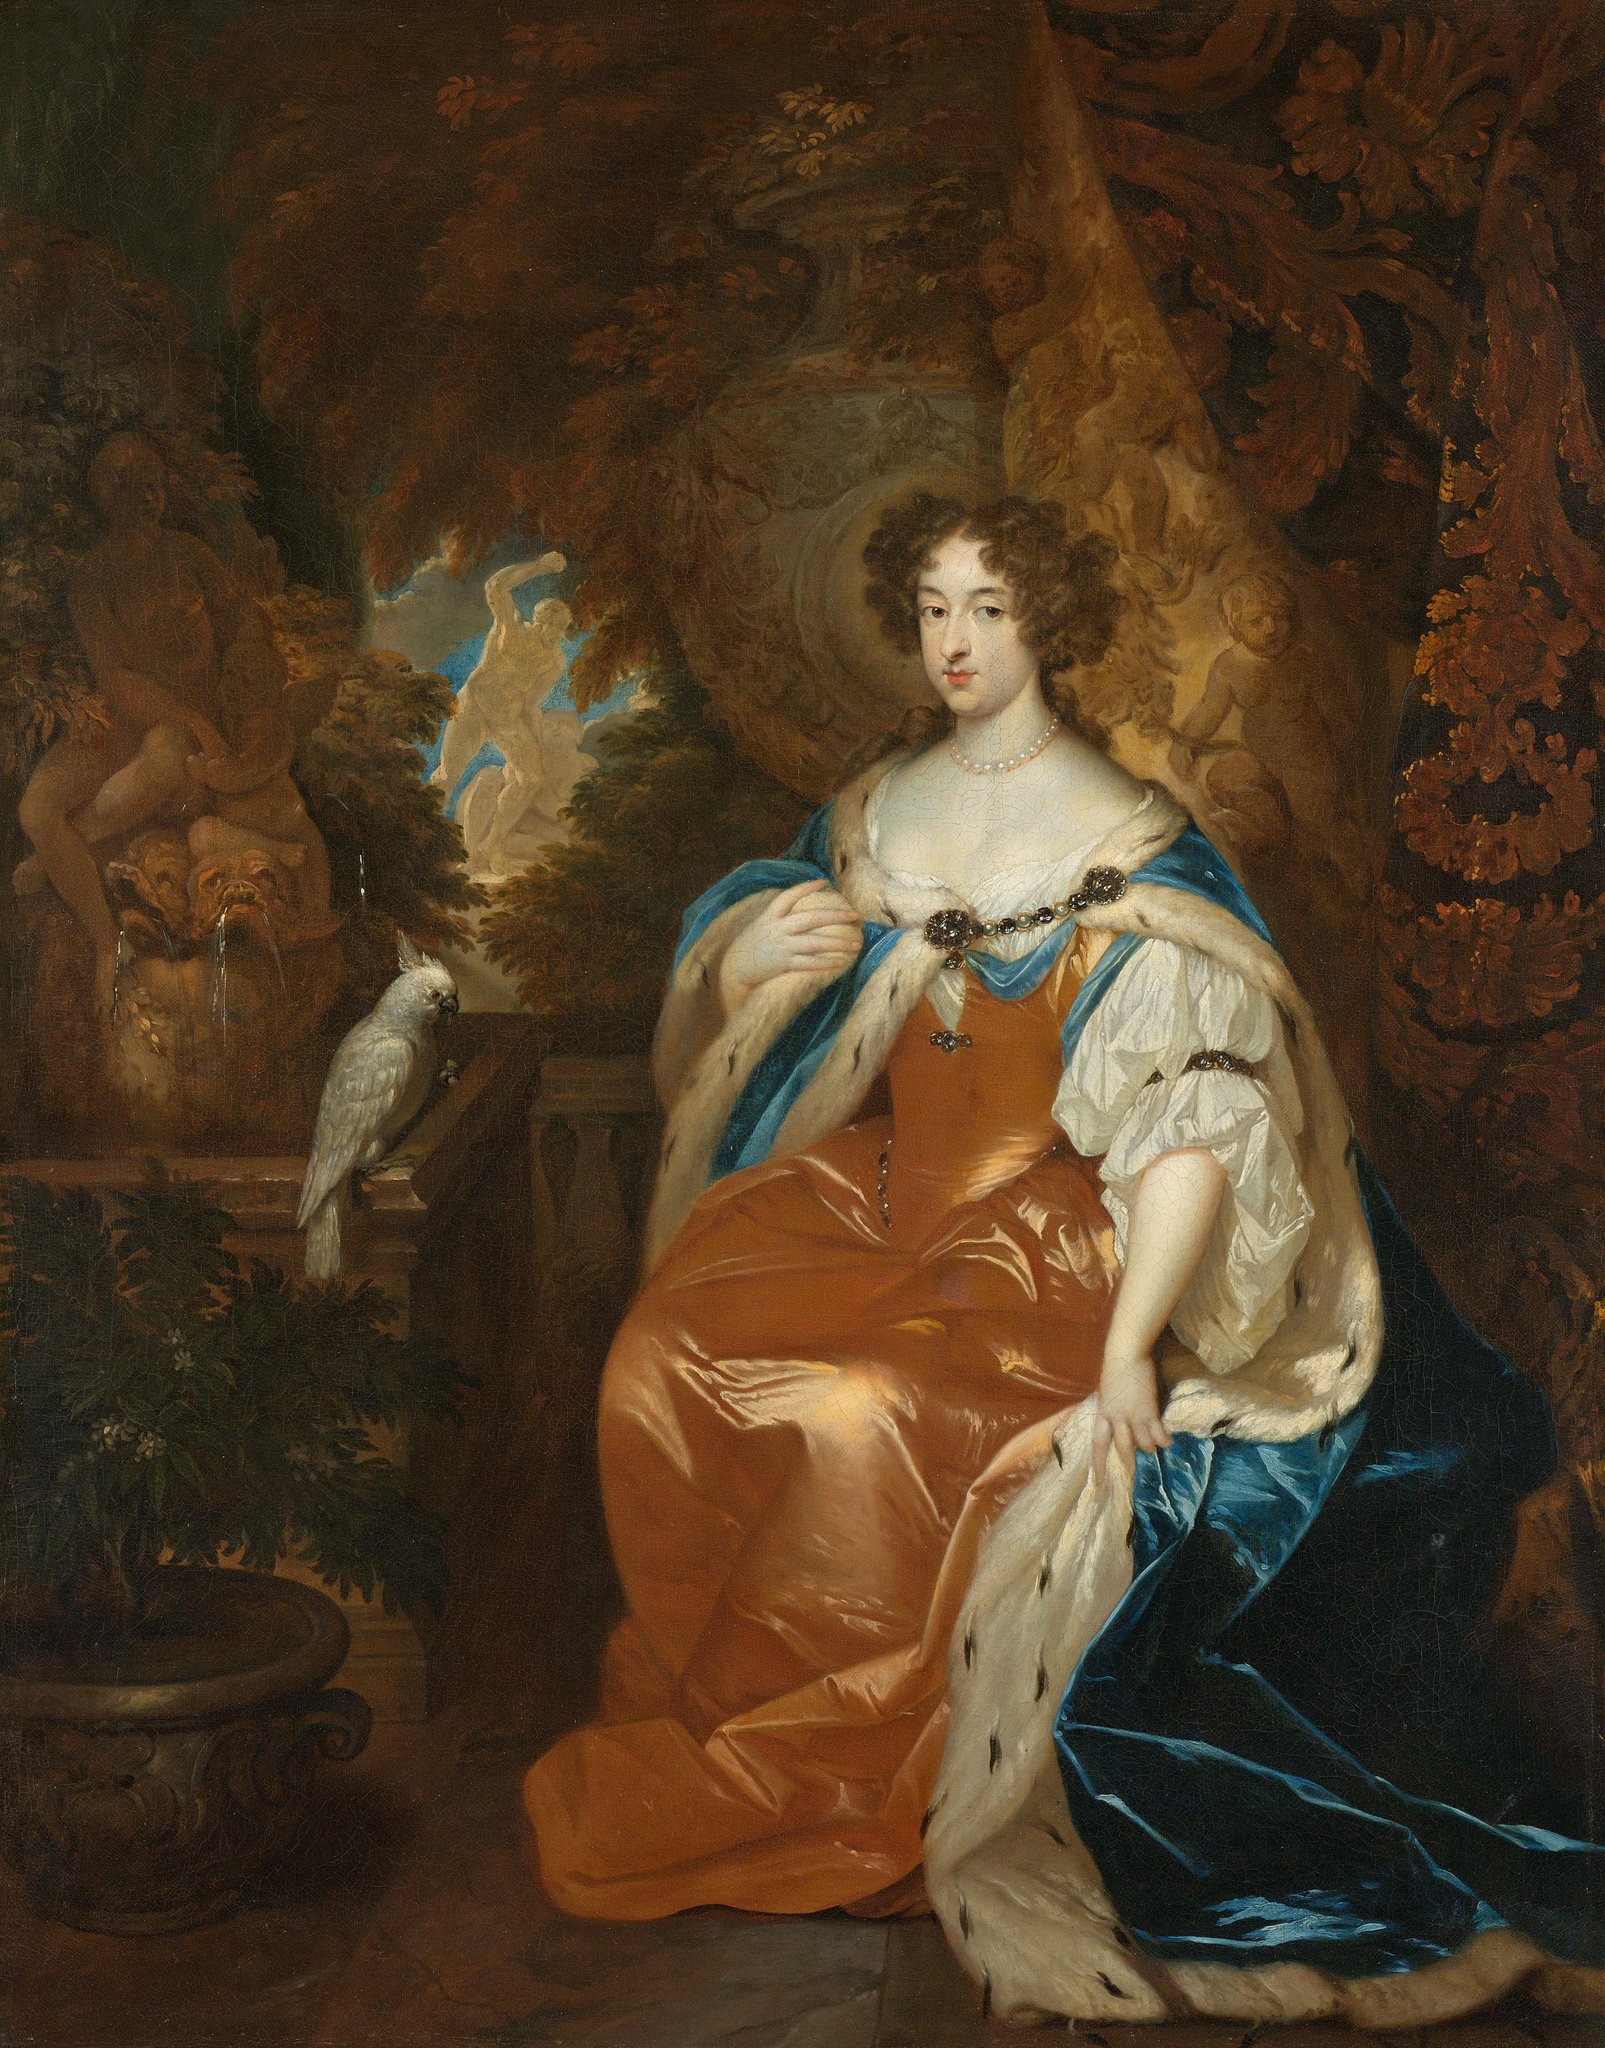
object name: painting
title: Portrait of Mary Stuart (1662-95), Wife of Prince William III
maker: caspar netscher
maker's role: draughtsman, painter, print maker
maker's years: 1639-1684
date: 1683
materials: canvas, oil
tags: maria ii stuart (koningin van engeland, schotland en ierland), historical persons - bb - woman, garden fountain, ornamental birds: parrot, queen, empress, etc. (wife of a ruler)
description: William III and Mary II by Caspar Netscher, between 1677 and 1684. In 1677 Stadholder William III married his niece Mary Stuart, daughter of the heir to the English throne, later James II. The two portraits form a pair. They were painted by Caspar Netscher, a popular portrait artist in The Hague. Mary is wearing an orange dress; the ermine cloak indicates her royal lineage. In contrast to the homely setting in which Mary is shown, William is depicted with acavalry battle in the background. He is wearing armour and beside him is a helmetwith an orange plume. William is carrying his staff of command. The stadholder was captain general of the army.